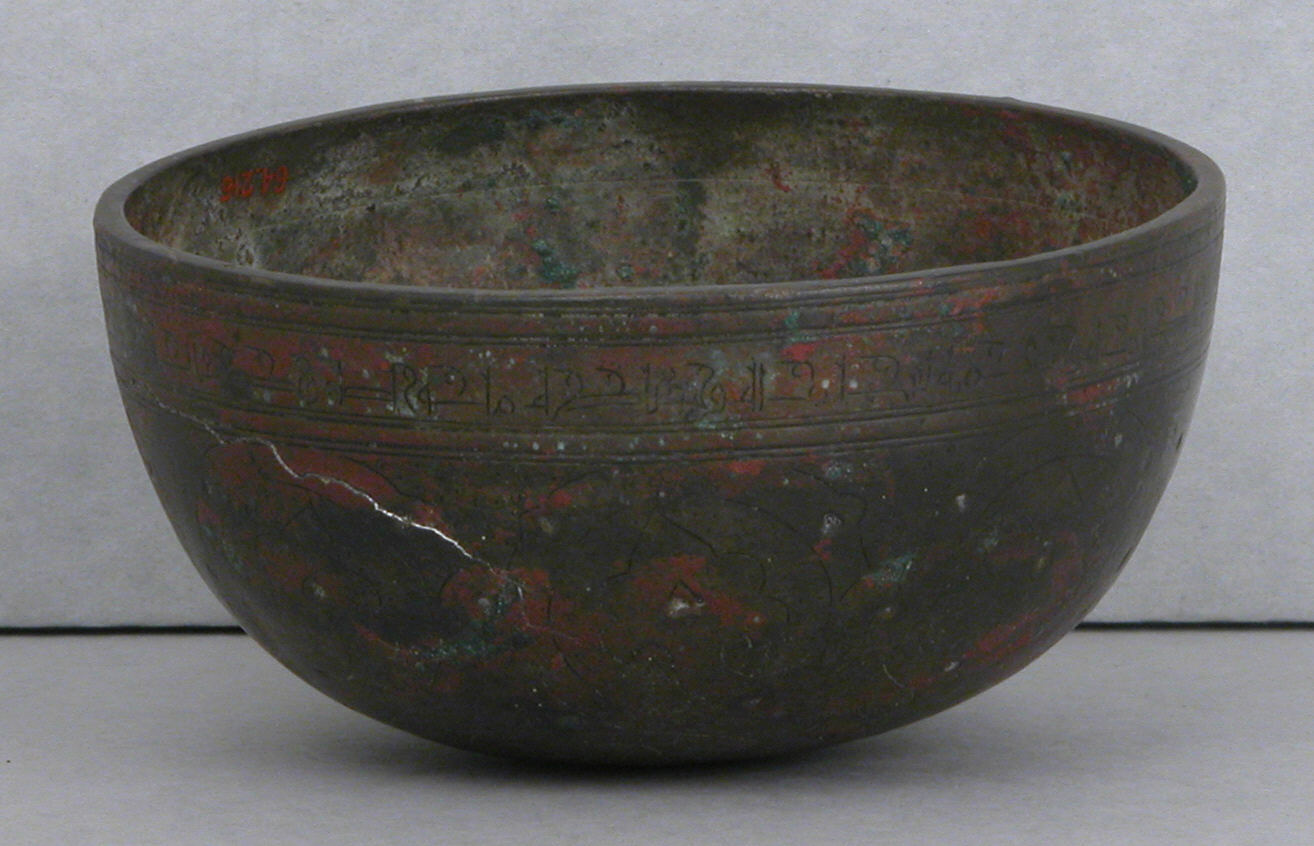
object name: bowl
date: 901-1100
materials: bronze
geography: iran